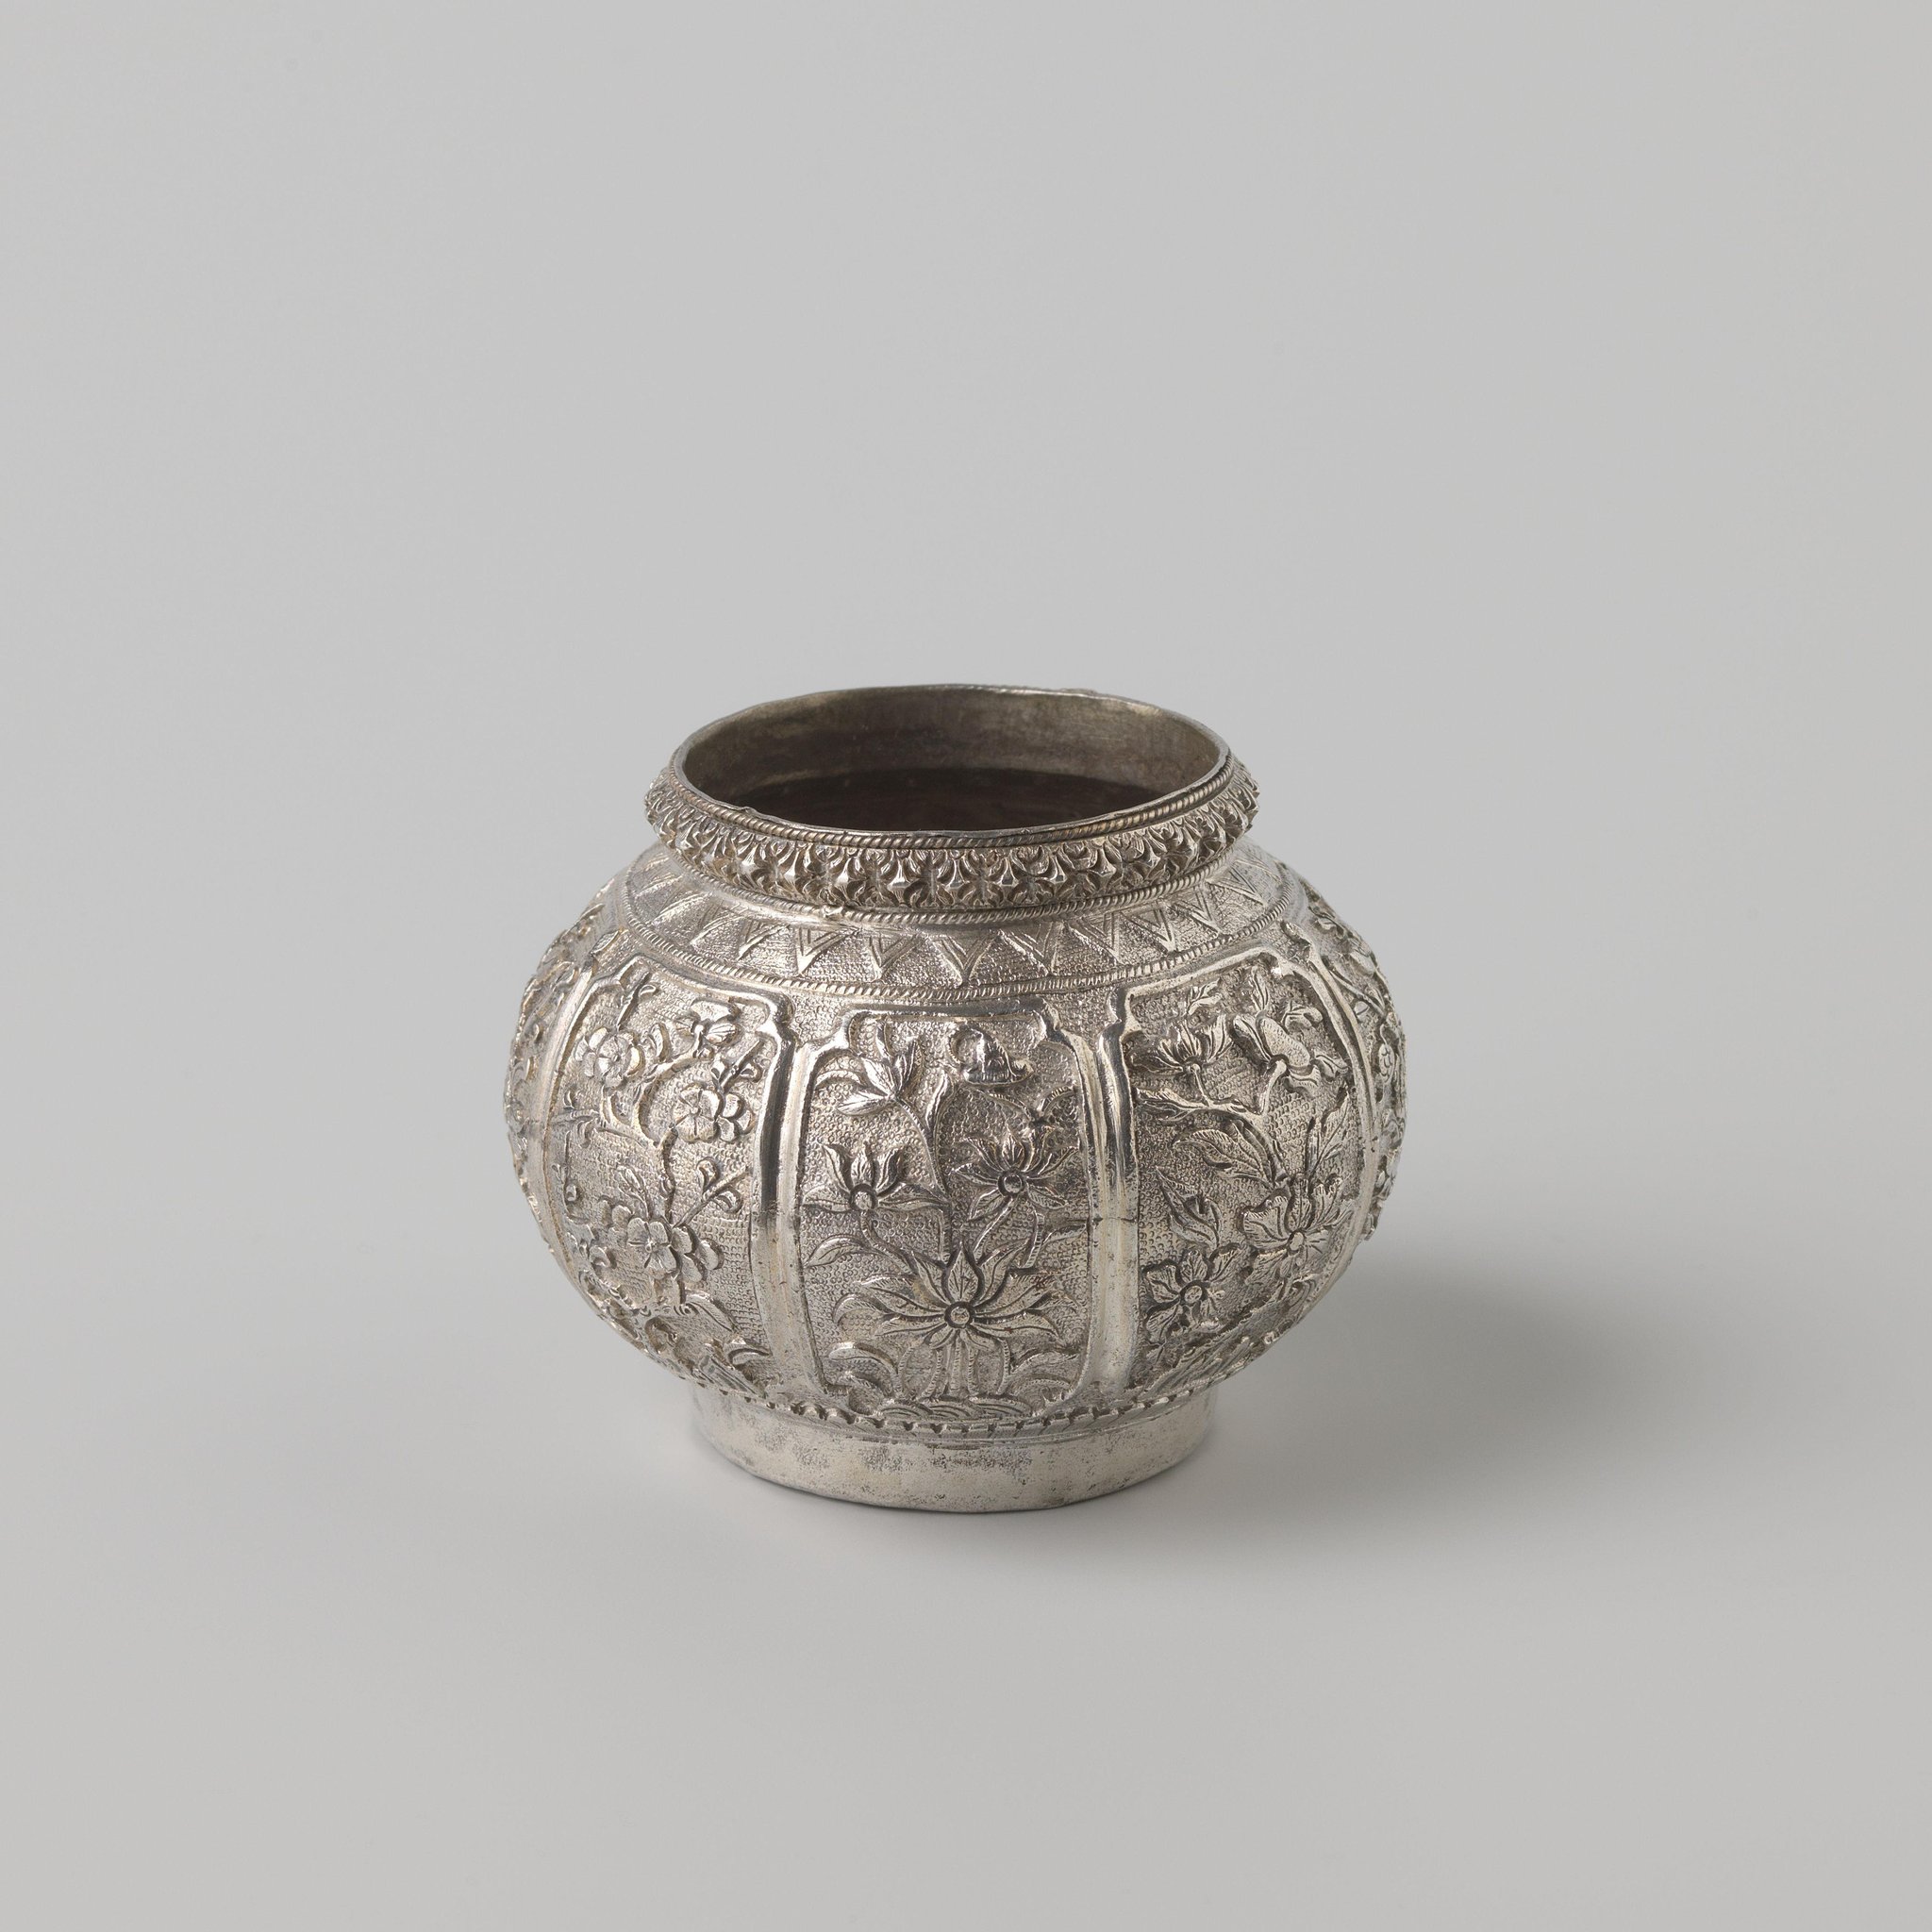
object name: pot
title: Zilveren potje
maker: Anonymous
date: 1700-1799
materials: silver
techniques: forging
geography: malaysia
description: Bolle potje op verhoogd plat voetje en met opstaande rand rond de opening. Geheel versierd met drijfwerk: acht taferelen met iedere keer verschillende bloemstukken. Opschrift ingekrast.